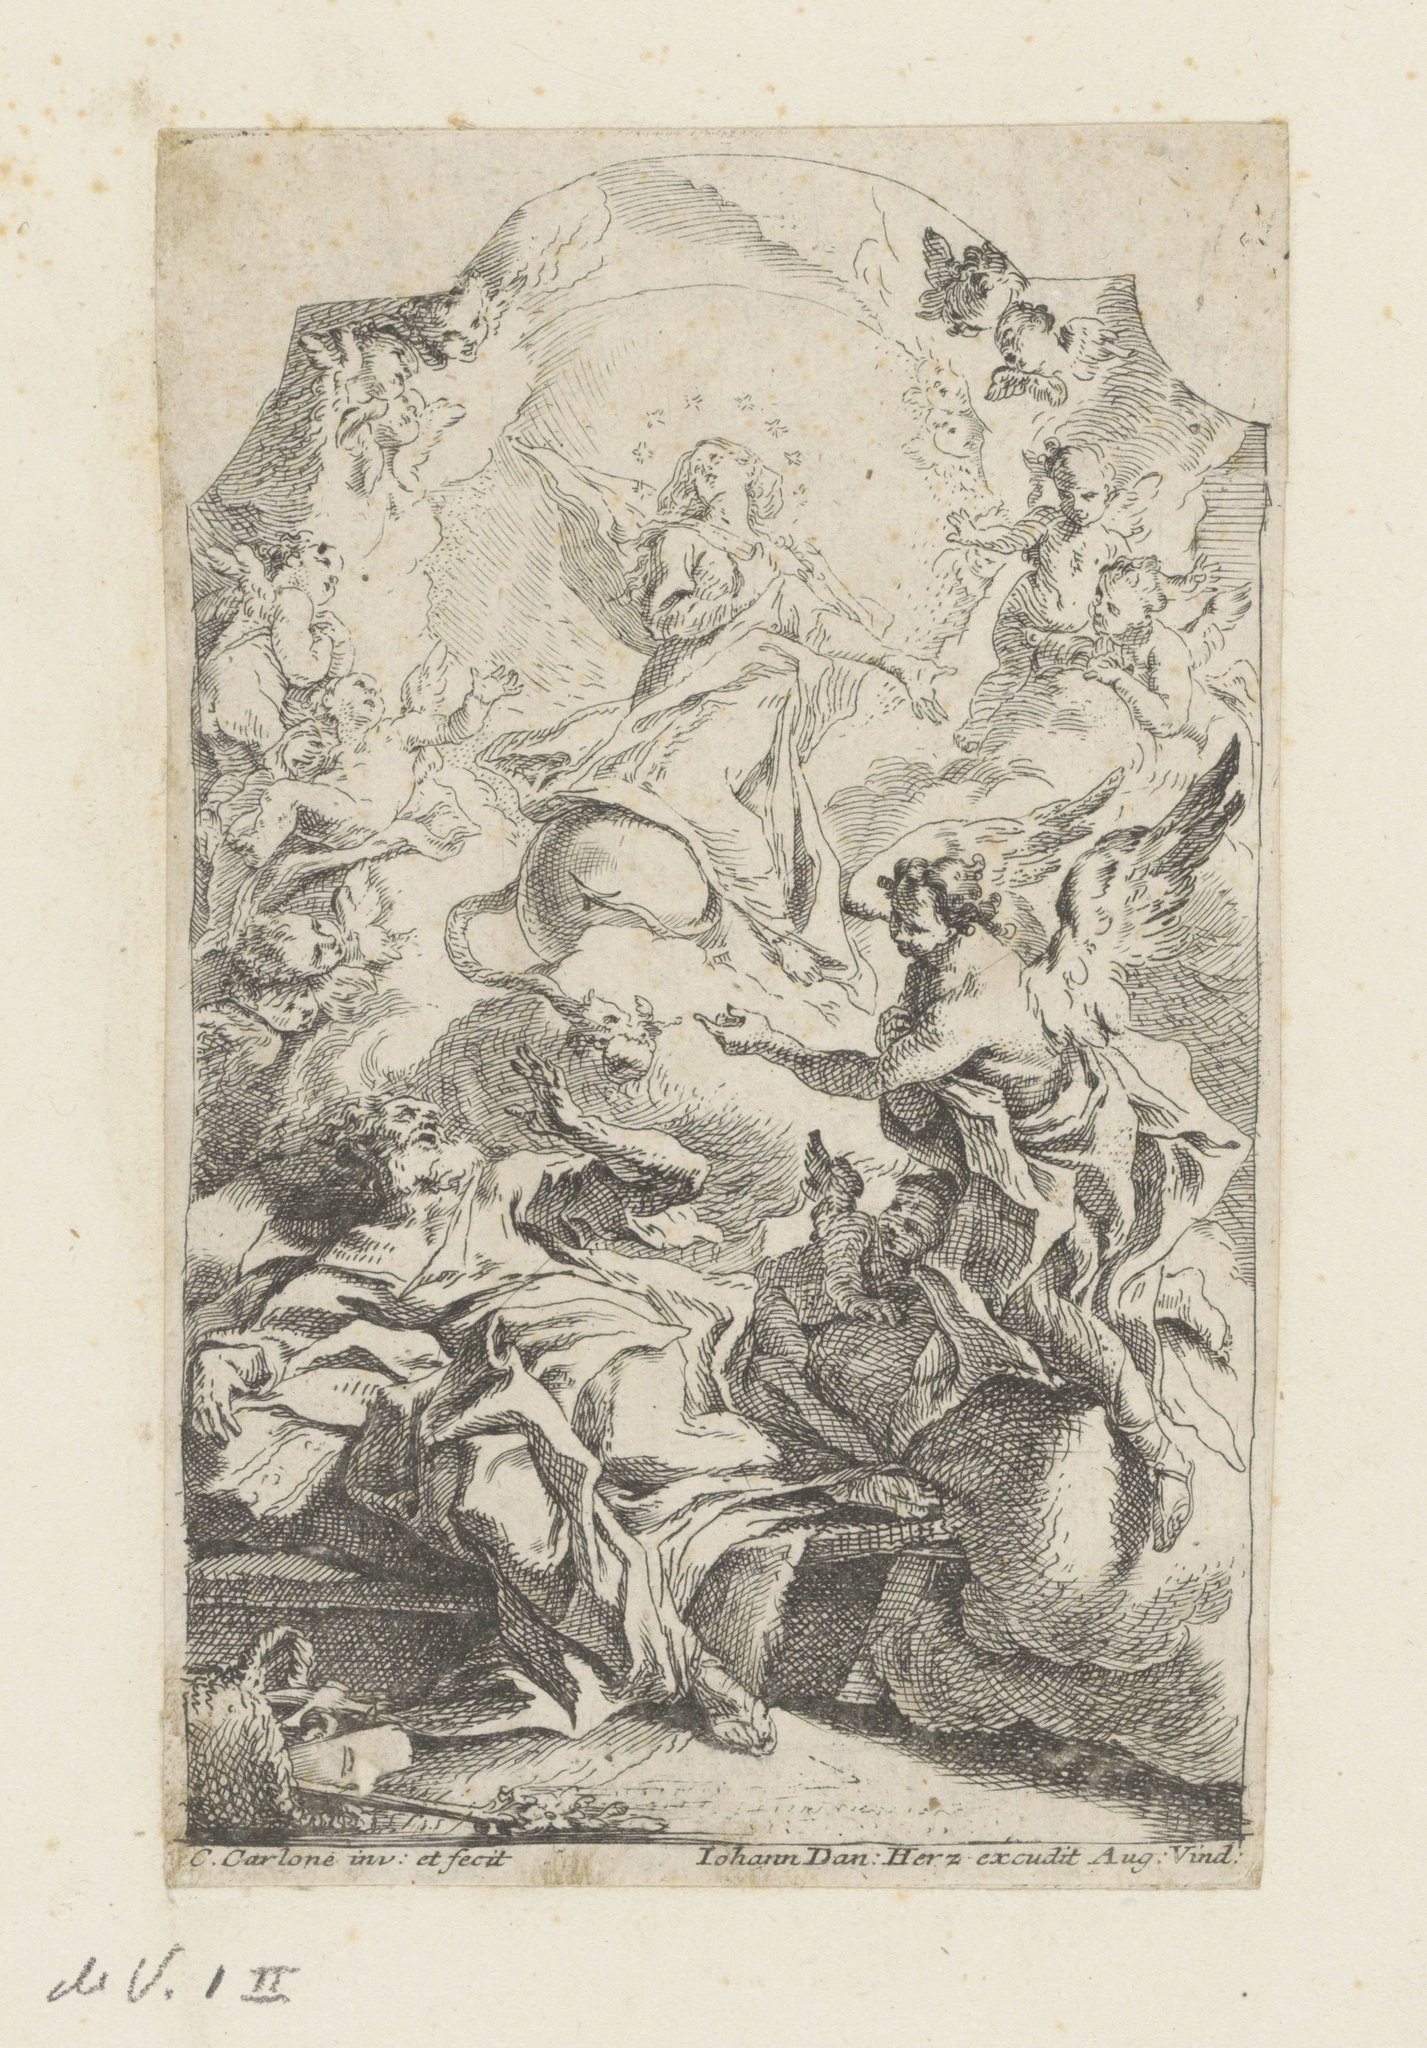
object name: print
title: Annunciatie aan Jozef in een droom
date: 1696-1775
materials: paper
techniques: etching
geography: augsburg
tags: joseph worrying about mary's pregnancy; annunciation to joseph in a dream (matthew 1:19:25)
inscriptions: collector's mark: Lugt 240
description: Jozef ligt te slapen. In zijn droom verschijnt er een engel die zijn huwelijk met Maria aankondigt. Maria staat op een globe. Om de globe kronkelt een slang met een appel in zijn bek. Rondom zweven engelen.